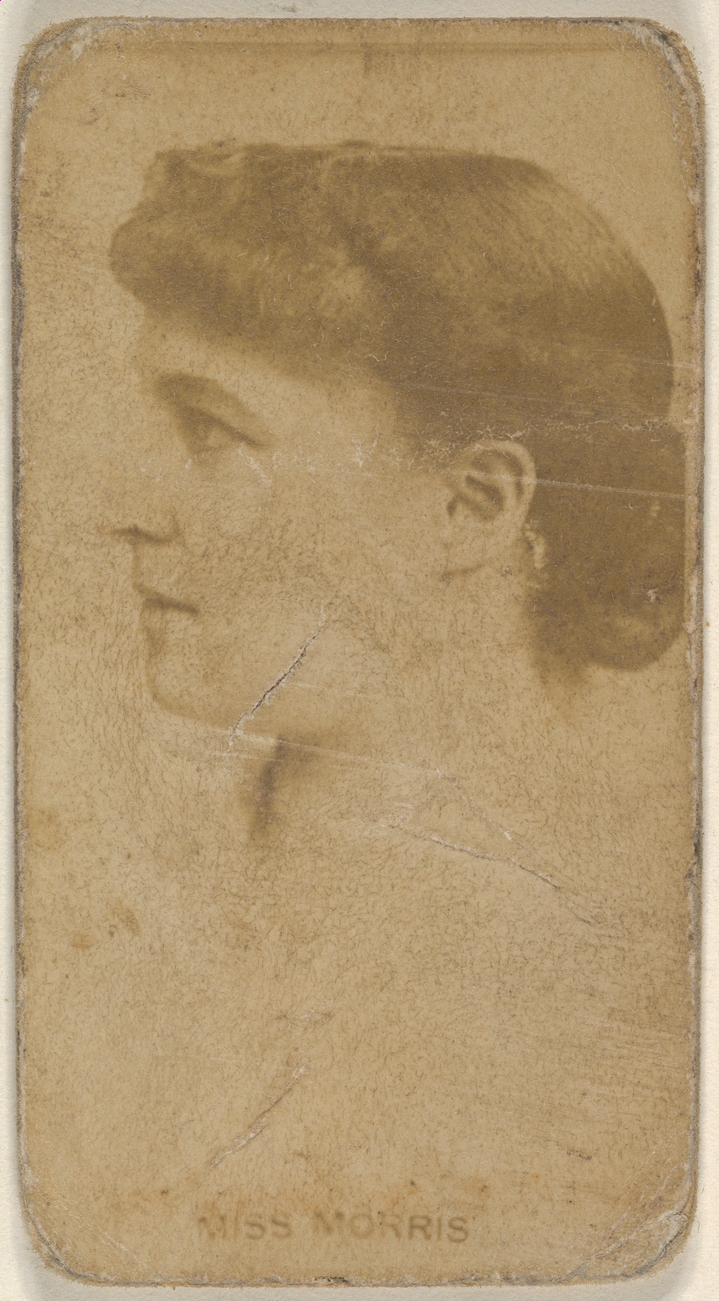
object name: photograph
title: Miss Morris, from the Actors and Actresses series (N45, Type 8) for Virginia Brights Cigarettes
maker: allen & ginter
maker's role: publisher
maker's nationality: american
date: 1888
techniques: albumen silver print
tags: portraits,women,actresses